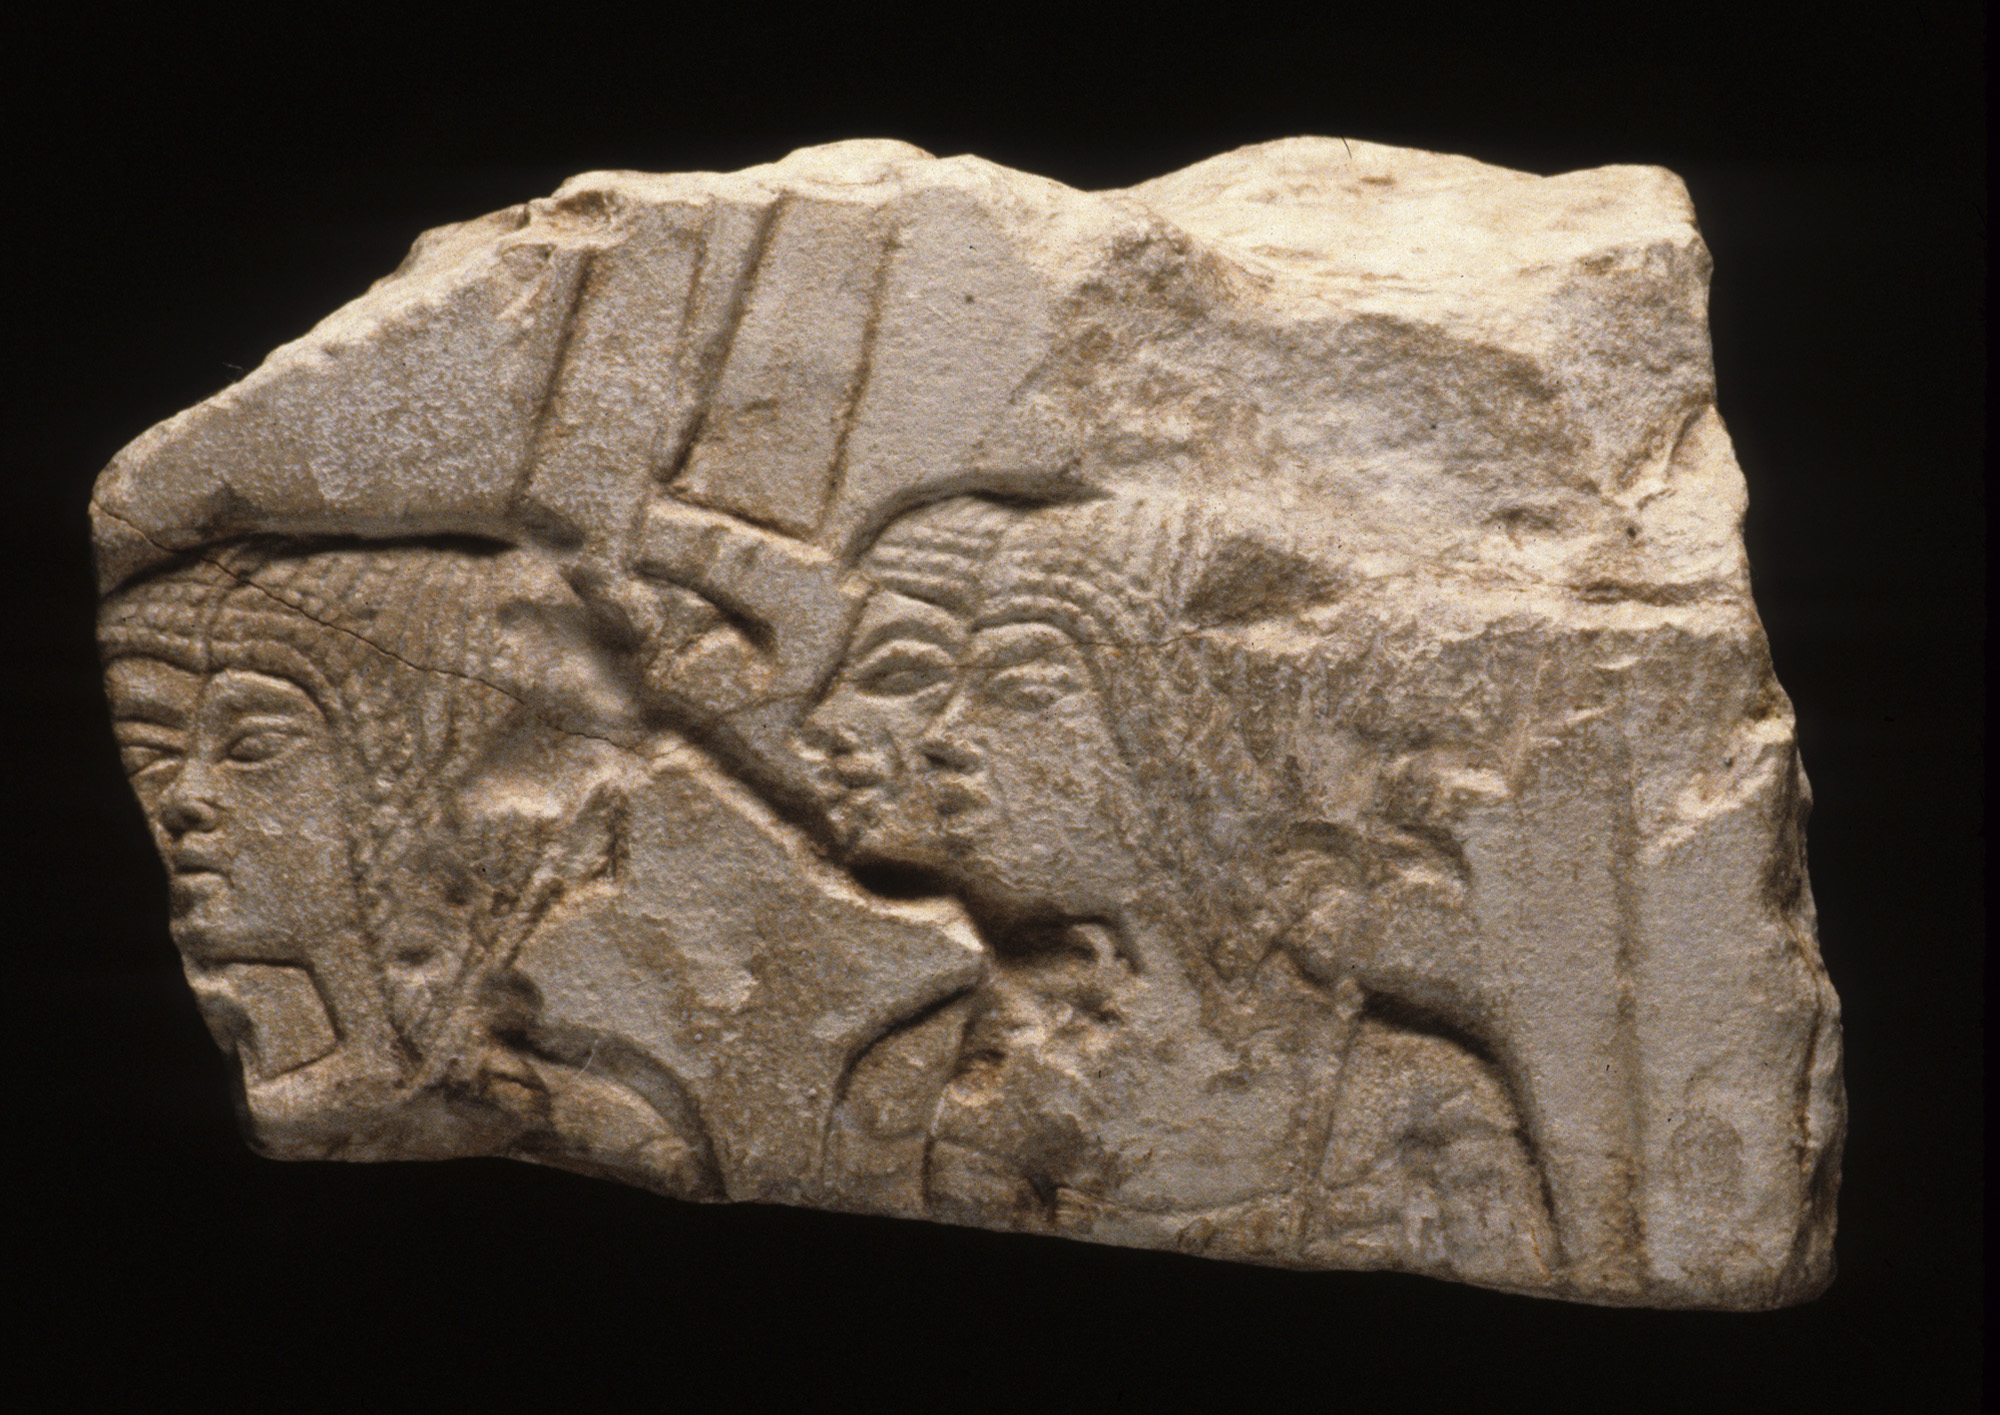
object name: stela fragment, head of courtier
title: Fragment of a Stela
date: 1353-1295 BCE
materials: limestone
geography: egypt